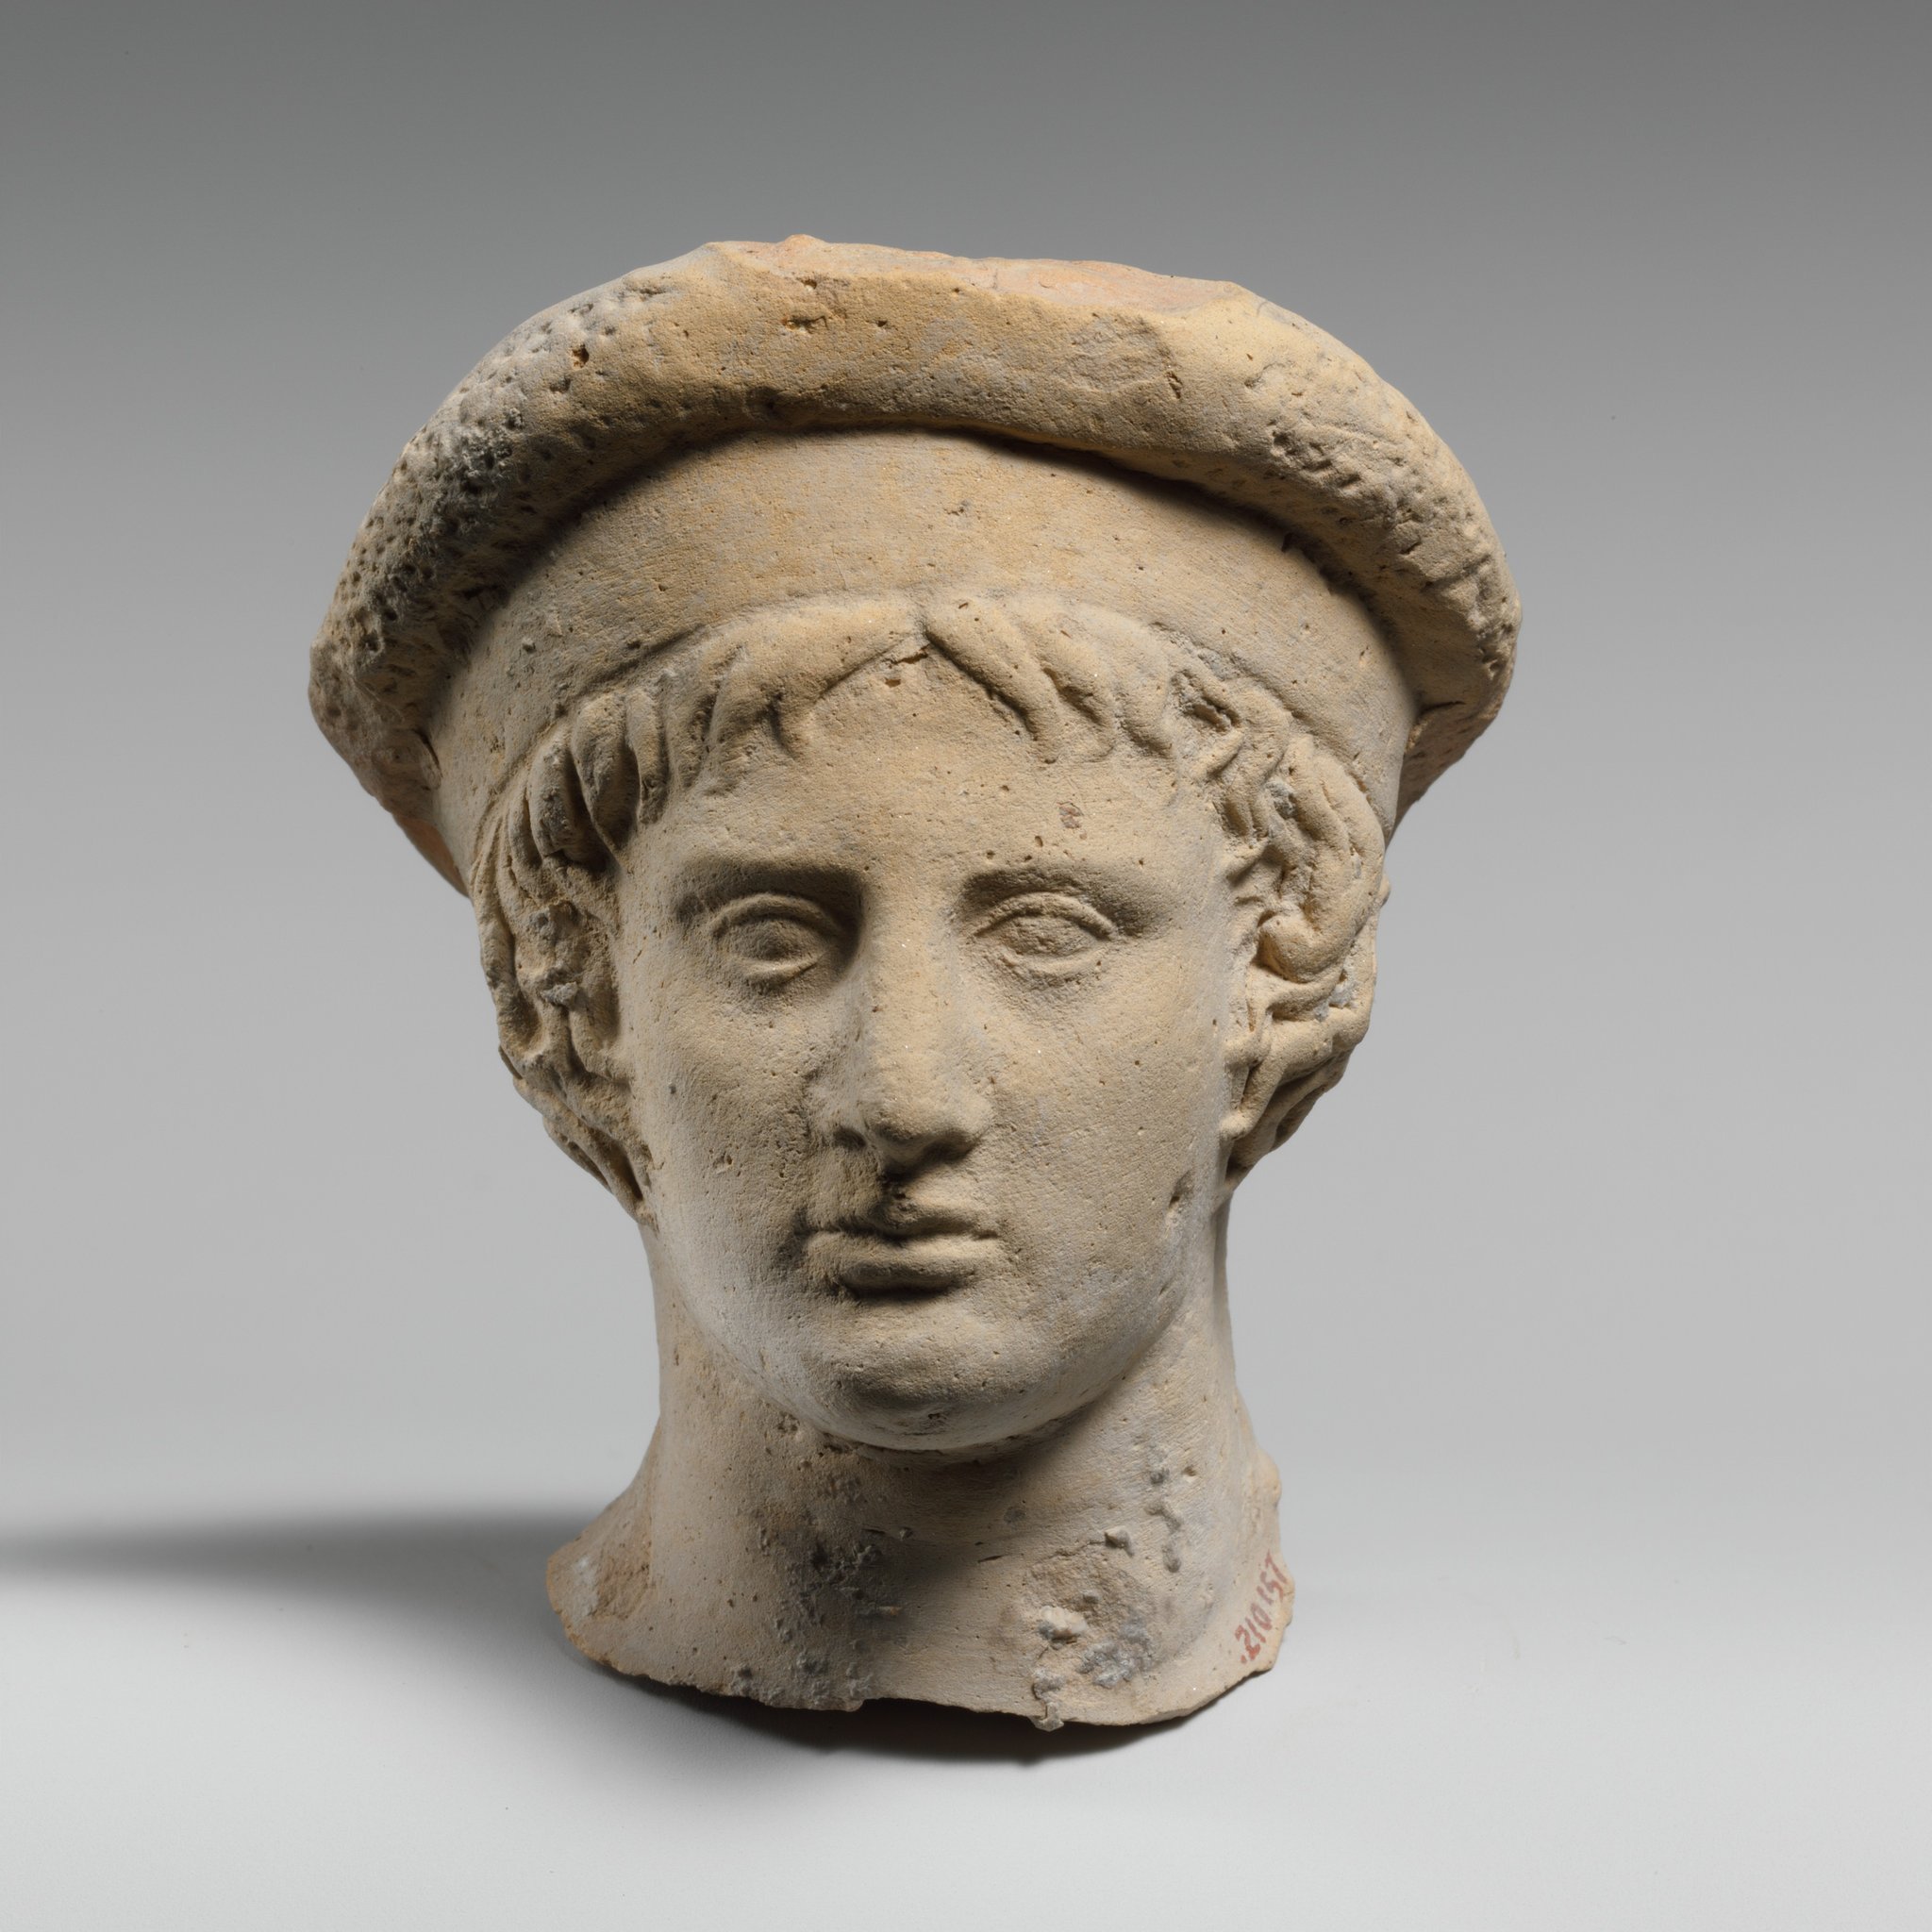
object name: head of a youth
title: Terracotta head of a youth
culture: greek, south italian, tarentine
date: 400-301 BCE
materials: terracotta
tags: heads,men